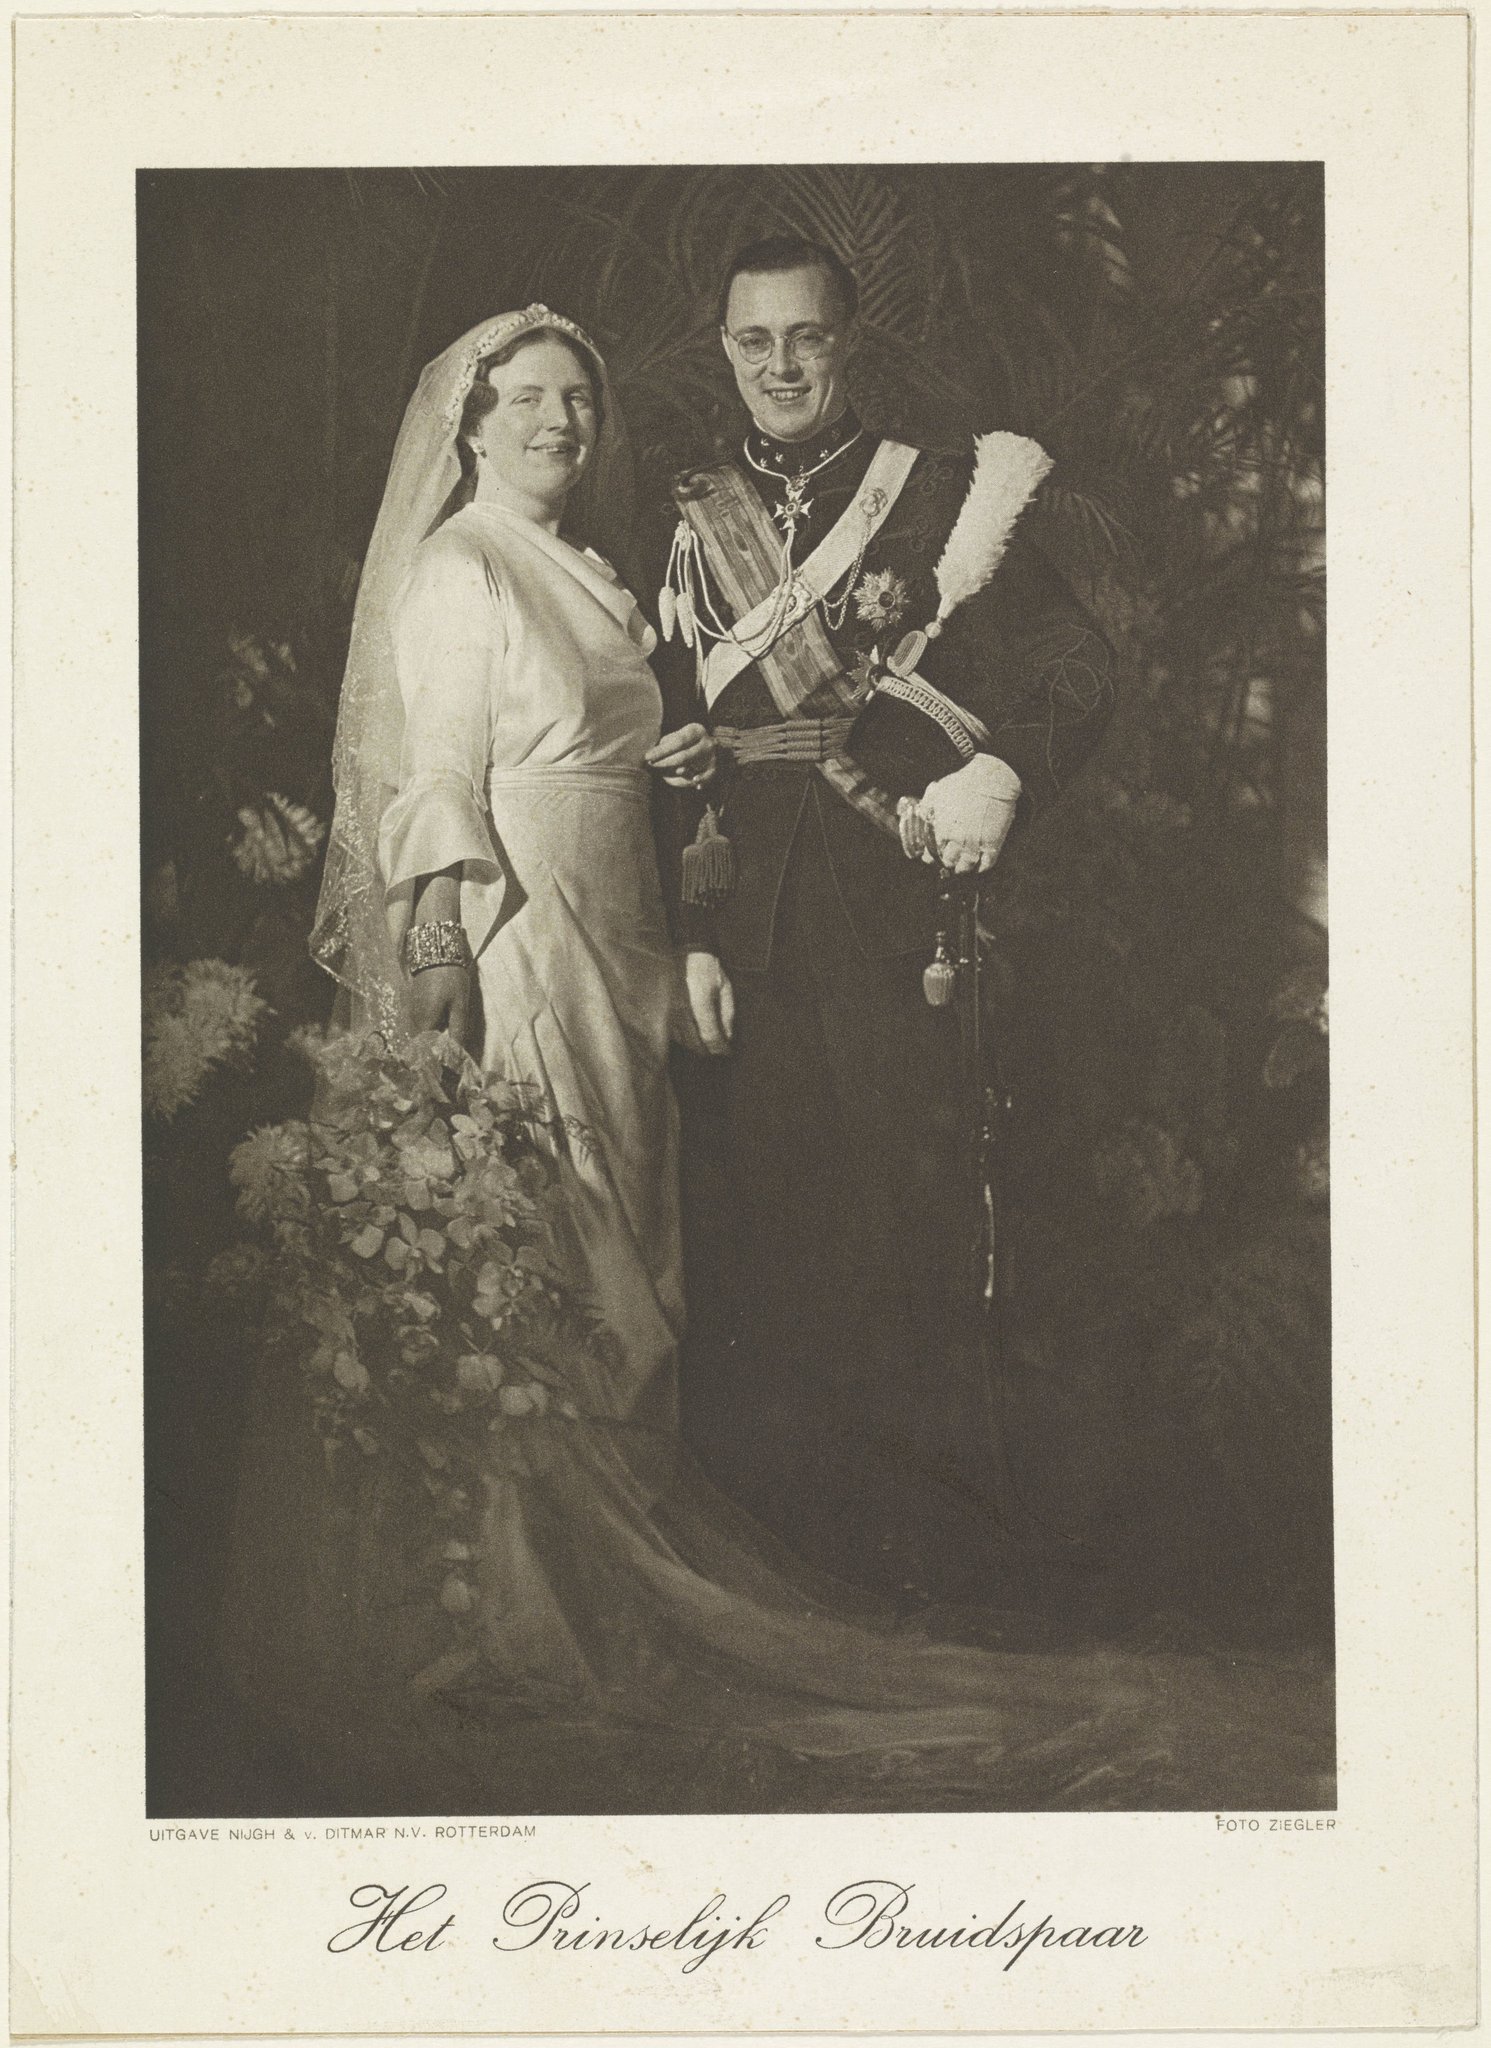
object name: photomechanical print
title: Portret van Juliana, koningin der Nederlanden, en Bernhard van Lippe-Biesterfeld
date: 1937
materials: paper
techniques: rotogravure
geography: netherlands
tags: utrecht, bernhard (prins der nederlanden), the hague, juliana of the netherlands, (civil) marriage ceremonies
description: Portret van Juliana en Bernhard. Vervaardigd ter gelegenheid van het huwelijk van Juliana en Bernhard in de Grote Kerk te Den Haag op 7 januari 1937. In de ondermarge een regel Nederlandse tekst.